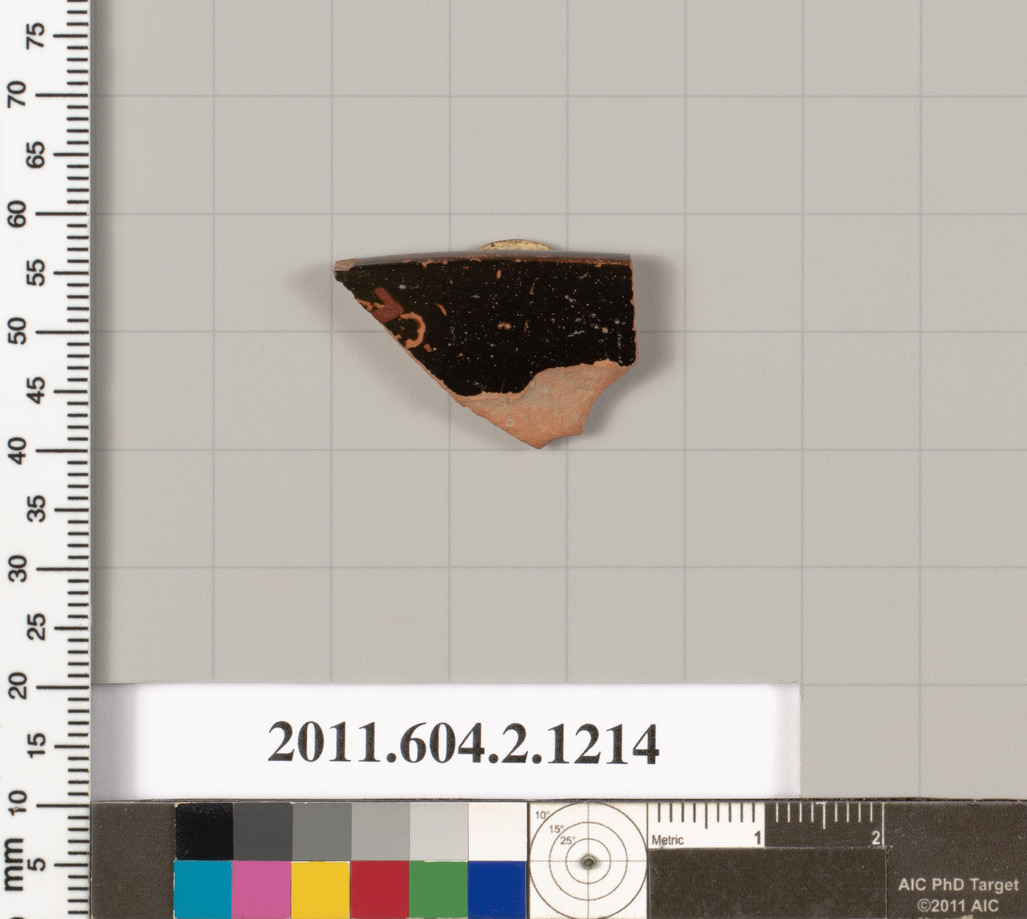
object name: kantharos fragment, head vase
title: Terracotta fragment from a kantharos: head vase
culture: greek, attic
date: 475-451 BCE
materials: terracotta